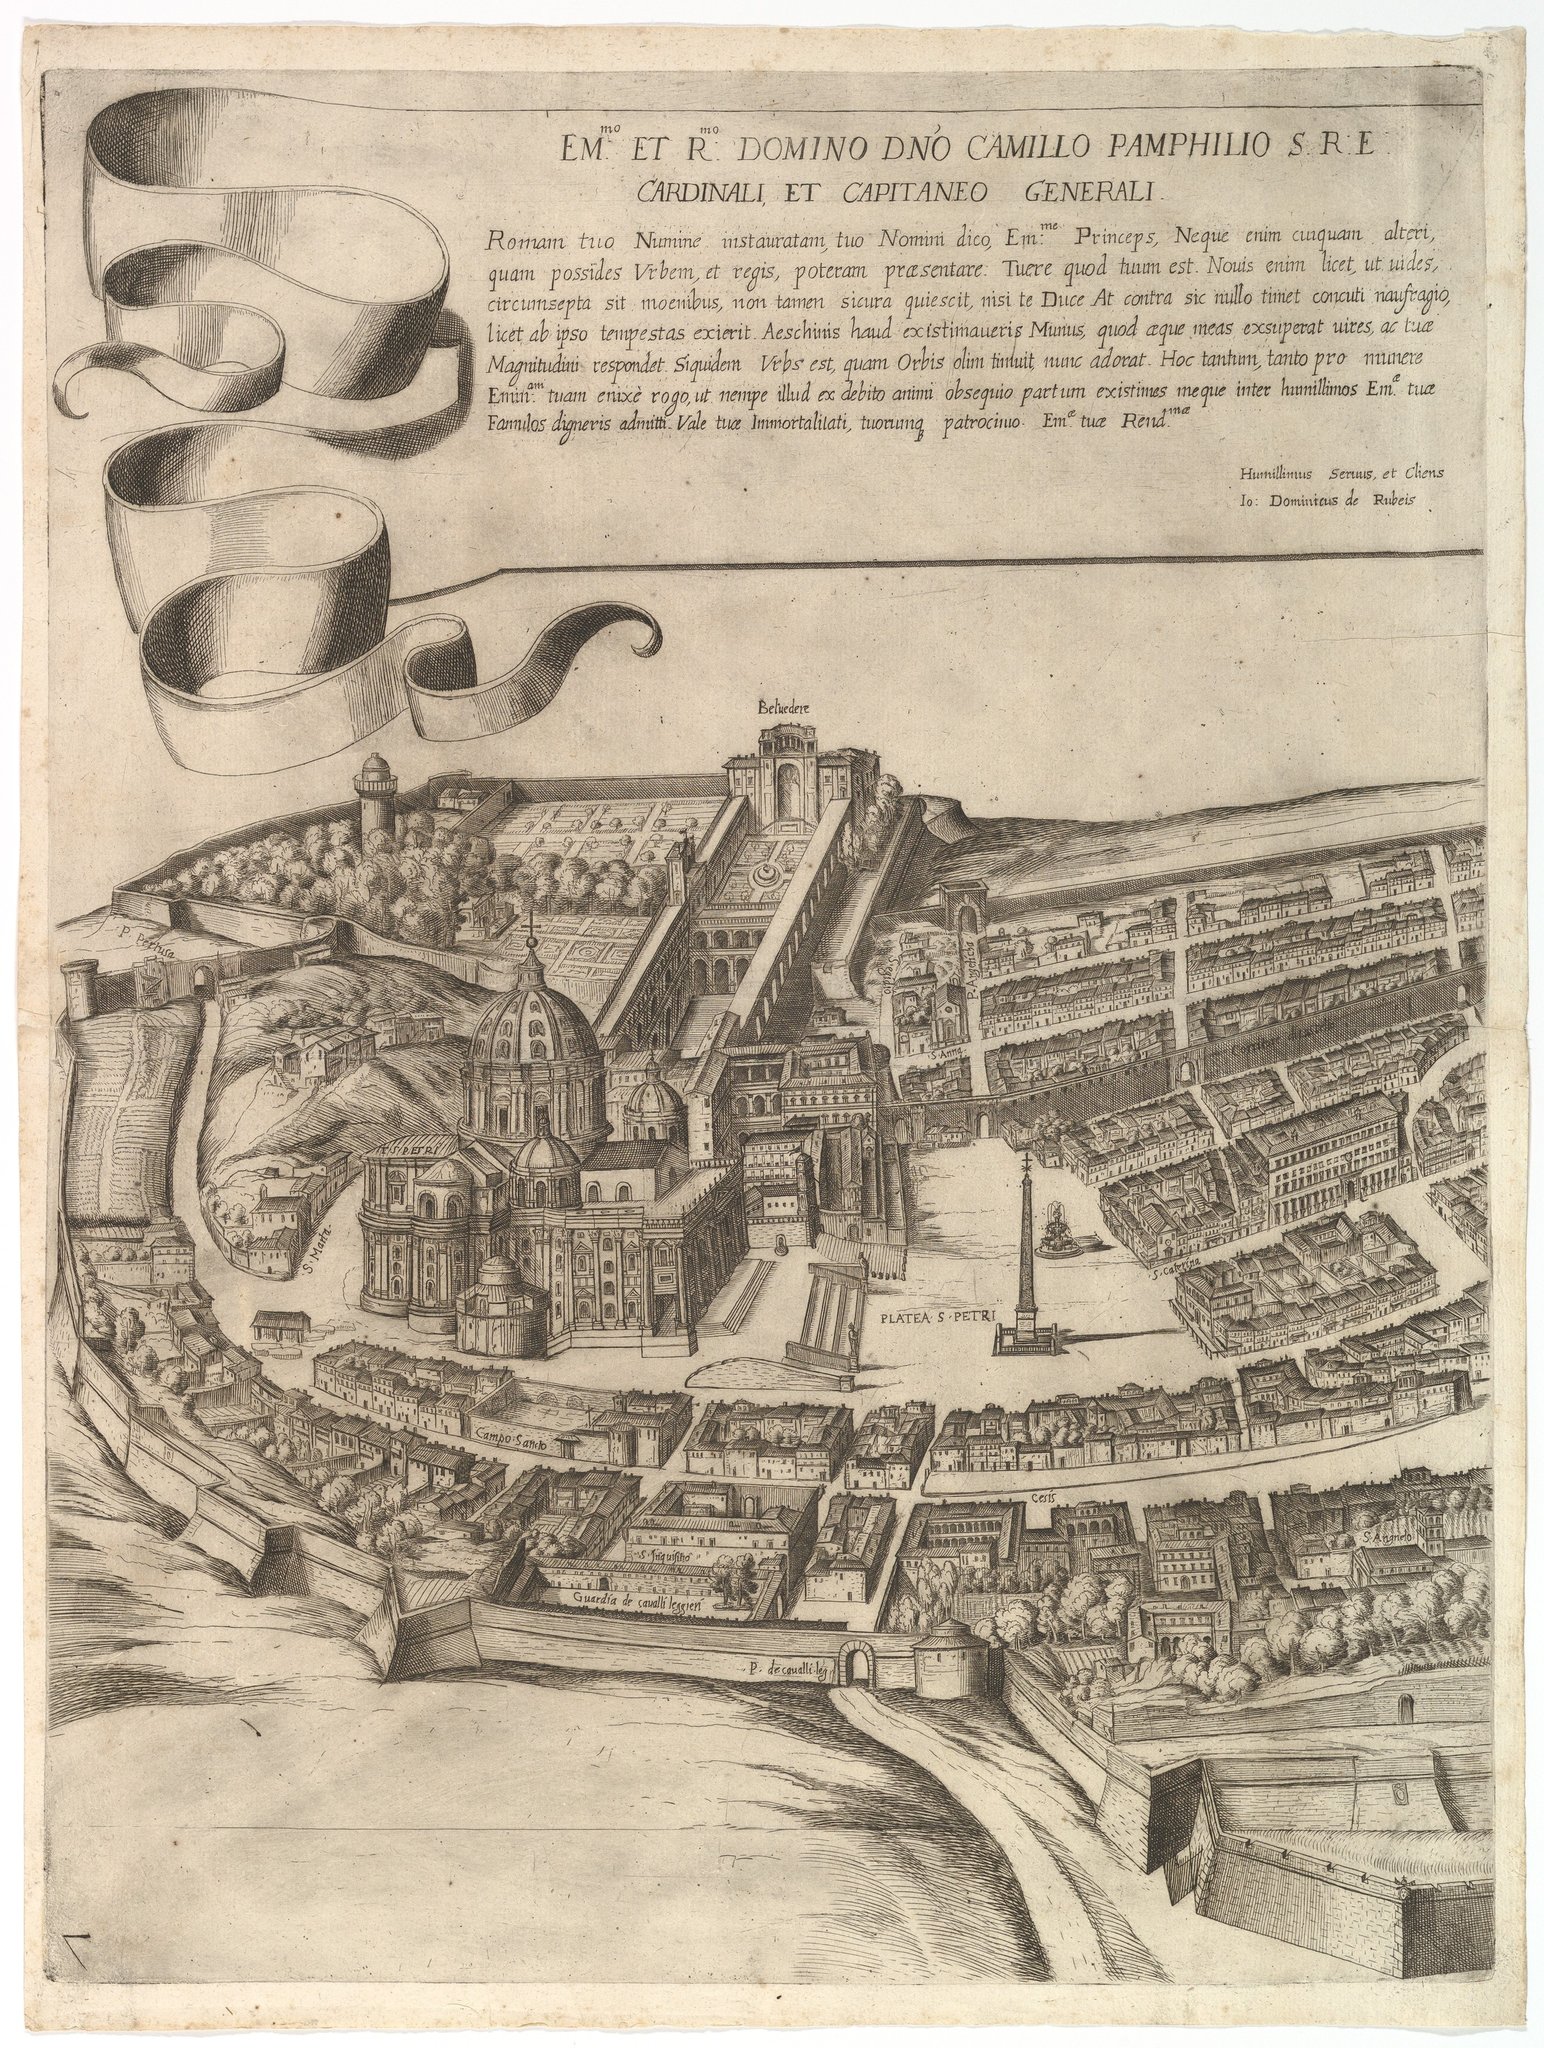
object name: print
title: Plan of the City of Rome. Part 7 with a Dedication to Camillo Pamphili, the Vatican and Part of the City Wall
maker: antonio tempesta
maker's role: artist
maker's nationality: italian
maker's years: 1555-1630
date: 1645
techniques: engraving, etching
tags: cities,maps,rome